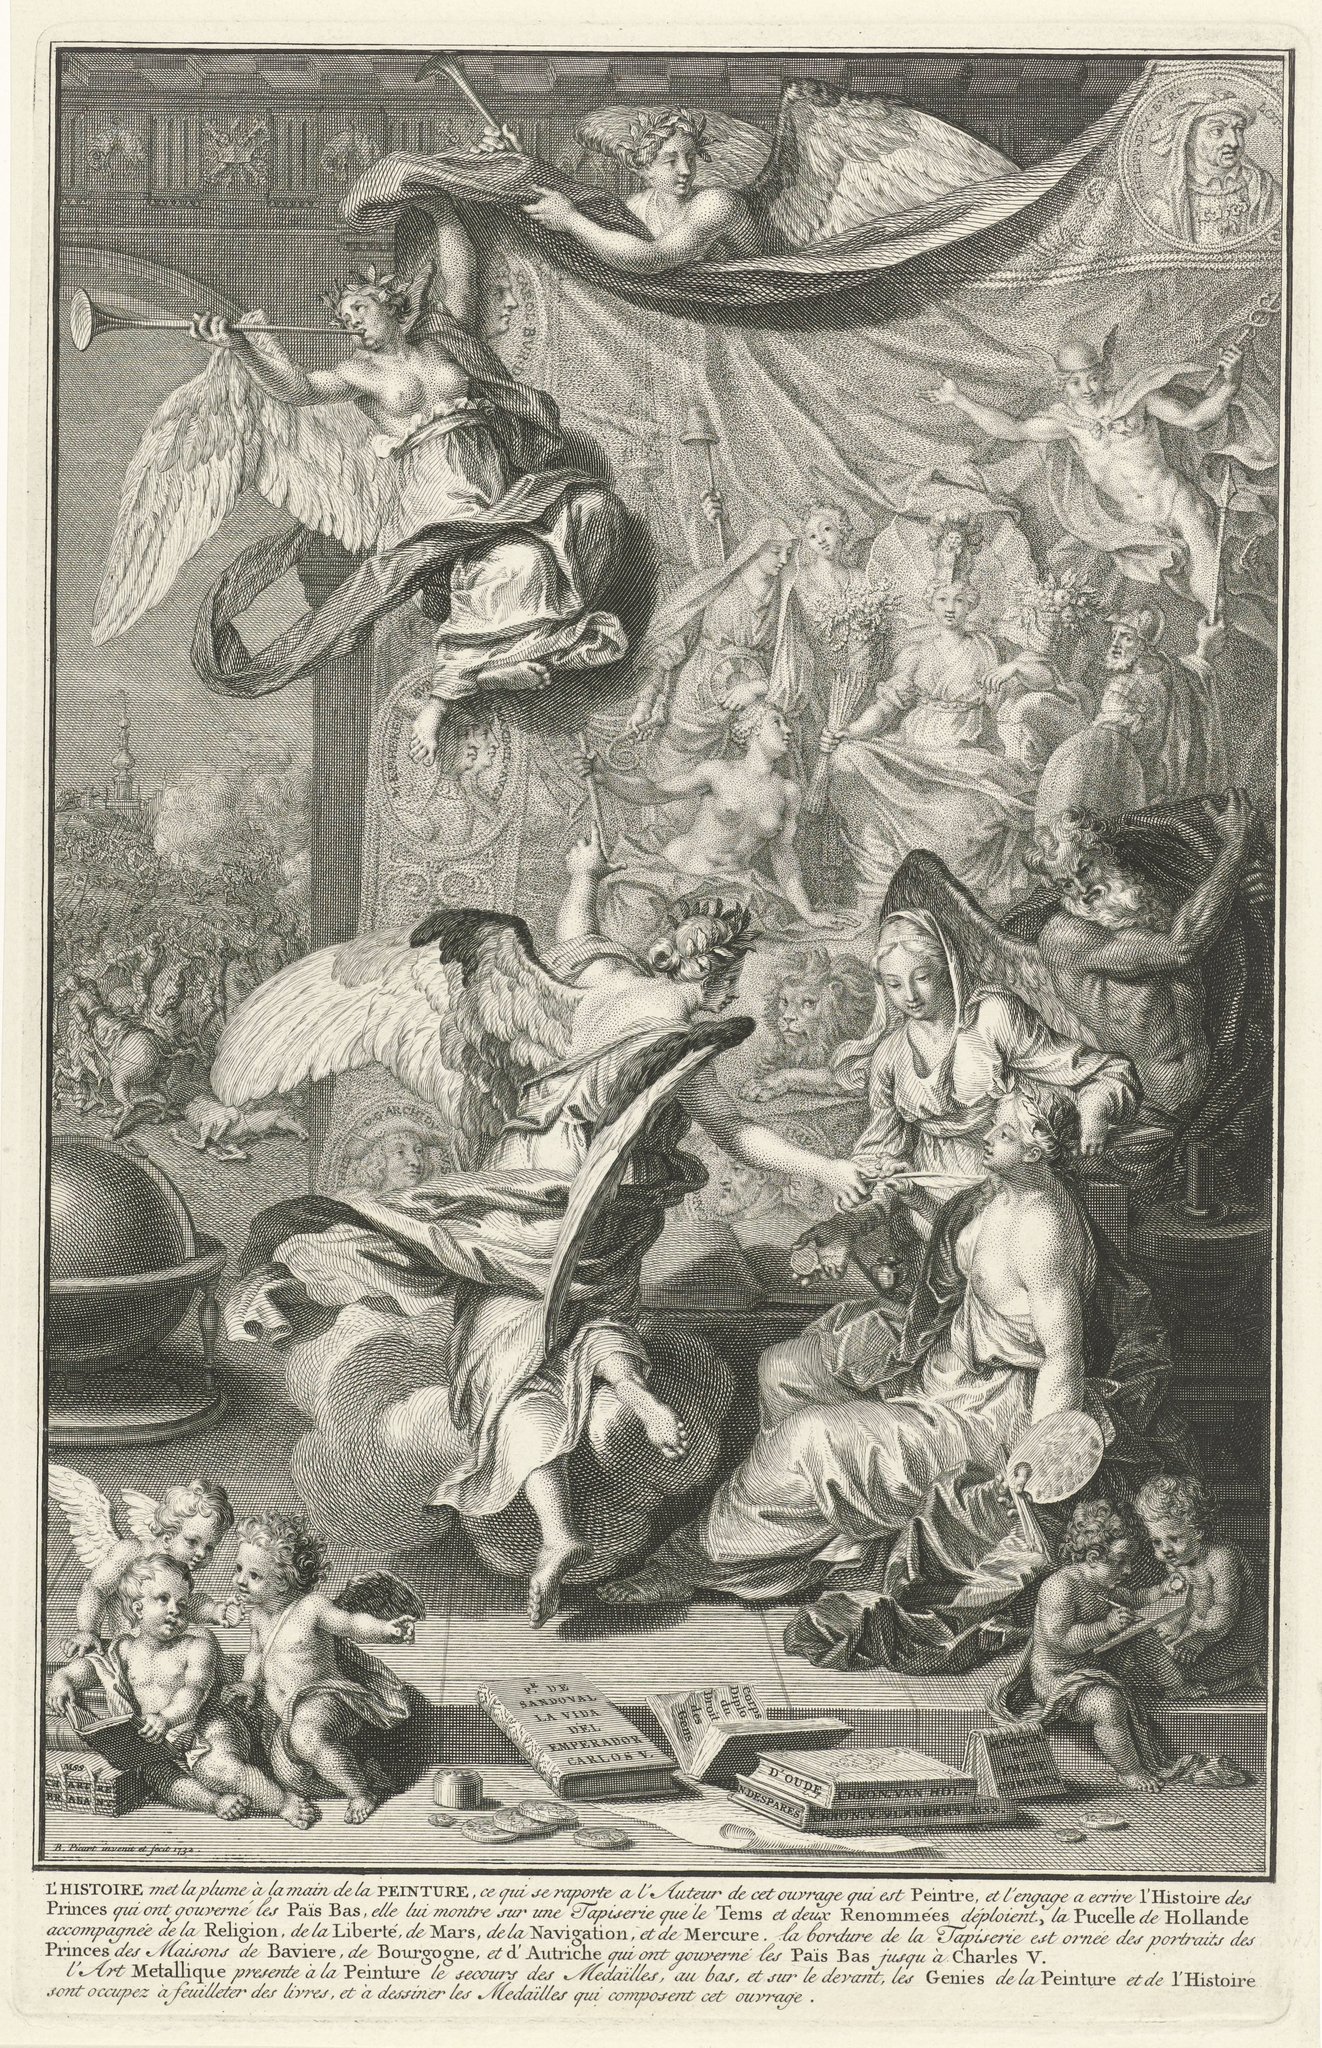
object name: titelblad, titelpagina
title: Titelpagina voor: F. van Mieris, Histori der Nederlandsche vorsten, 1732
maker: bernard picart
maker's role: draughtsman, print maker, publisher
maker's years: 1673-1733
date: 1732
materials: paper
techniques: engraving, etching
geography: amsterdam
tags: ghent, charles v (holy roman emperor and king of spain), (story of) mars (ares), faith, 'fides'; 'fede', 'fede catholica', 'fede christiana', 'fede christiana catholica' (ripa) ~ one of the three theological virtues, 'pictura', symbolic representations, allegories and emblems ~ painting; 'pittura' (ripa), personifications of countries, nations, states, districts, etc., (story of) thetis; 'thethi, ninfa del mare' (ripa), 'historia'; 'historia' (ripa), fame; 'fama', 'fama buona', 'fama chiara' (ripa), freedom, liberty; 'libertà' (ripa), father time, man with wings and scythe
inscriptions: collector's mark: Lugt 240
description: Allegorische voorstelling waarin Geschiedenis de Schilderkunst een schrijfveer in de hand geeft om de geschiedenissen van de Nederlandse vorsten op te tekenen. Ze wijst op een tapijt waarop de Nederlandse Maagd, vergezeld door Vrijheid, Geloof, Thetis, Mars en Mercurius en langs de randen medaillons waarin de portretten van Nederlandse vorsten. Links op de achtergrond een veldslag. Met een zesregelig onderschrift in het Frans.